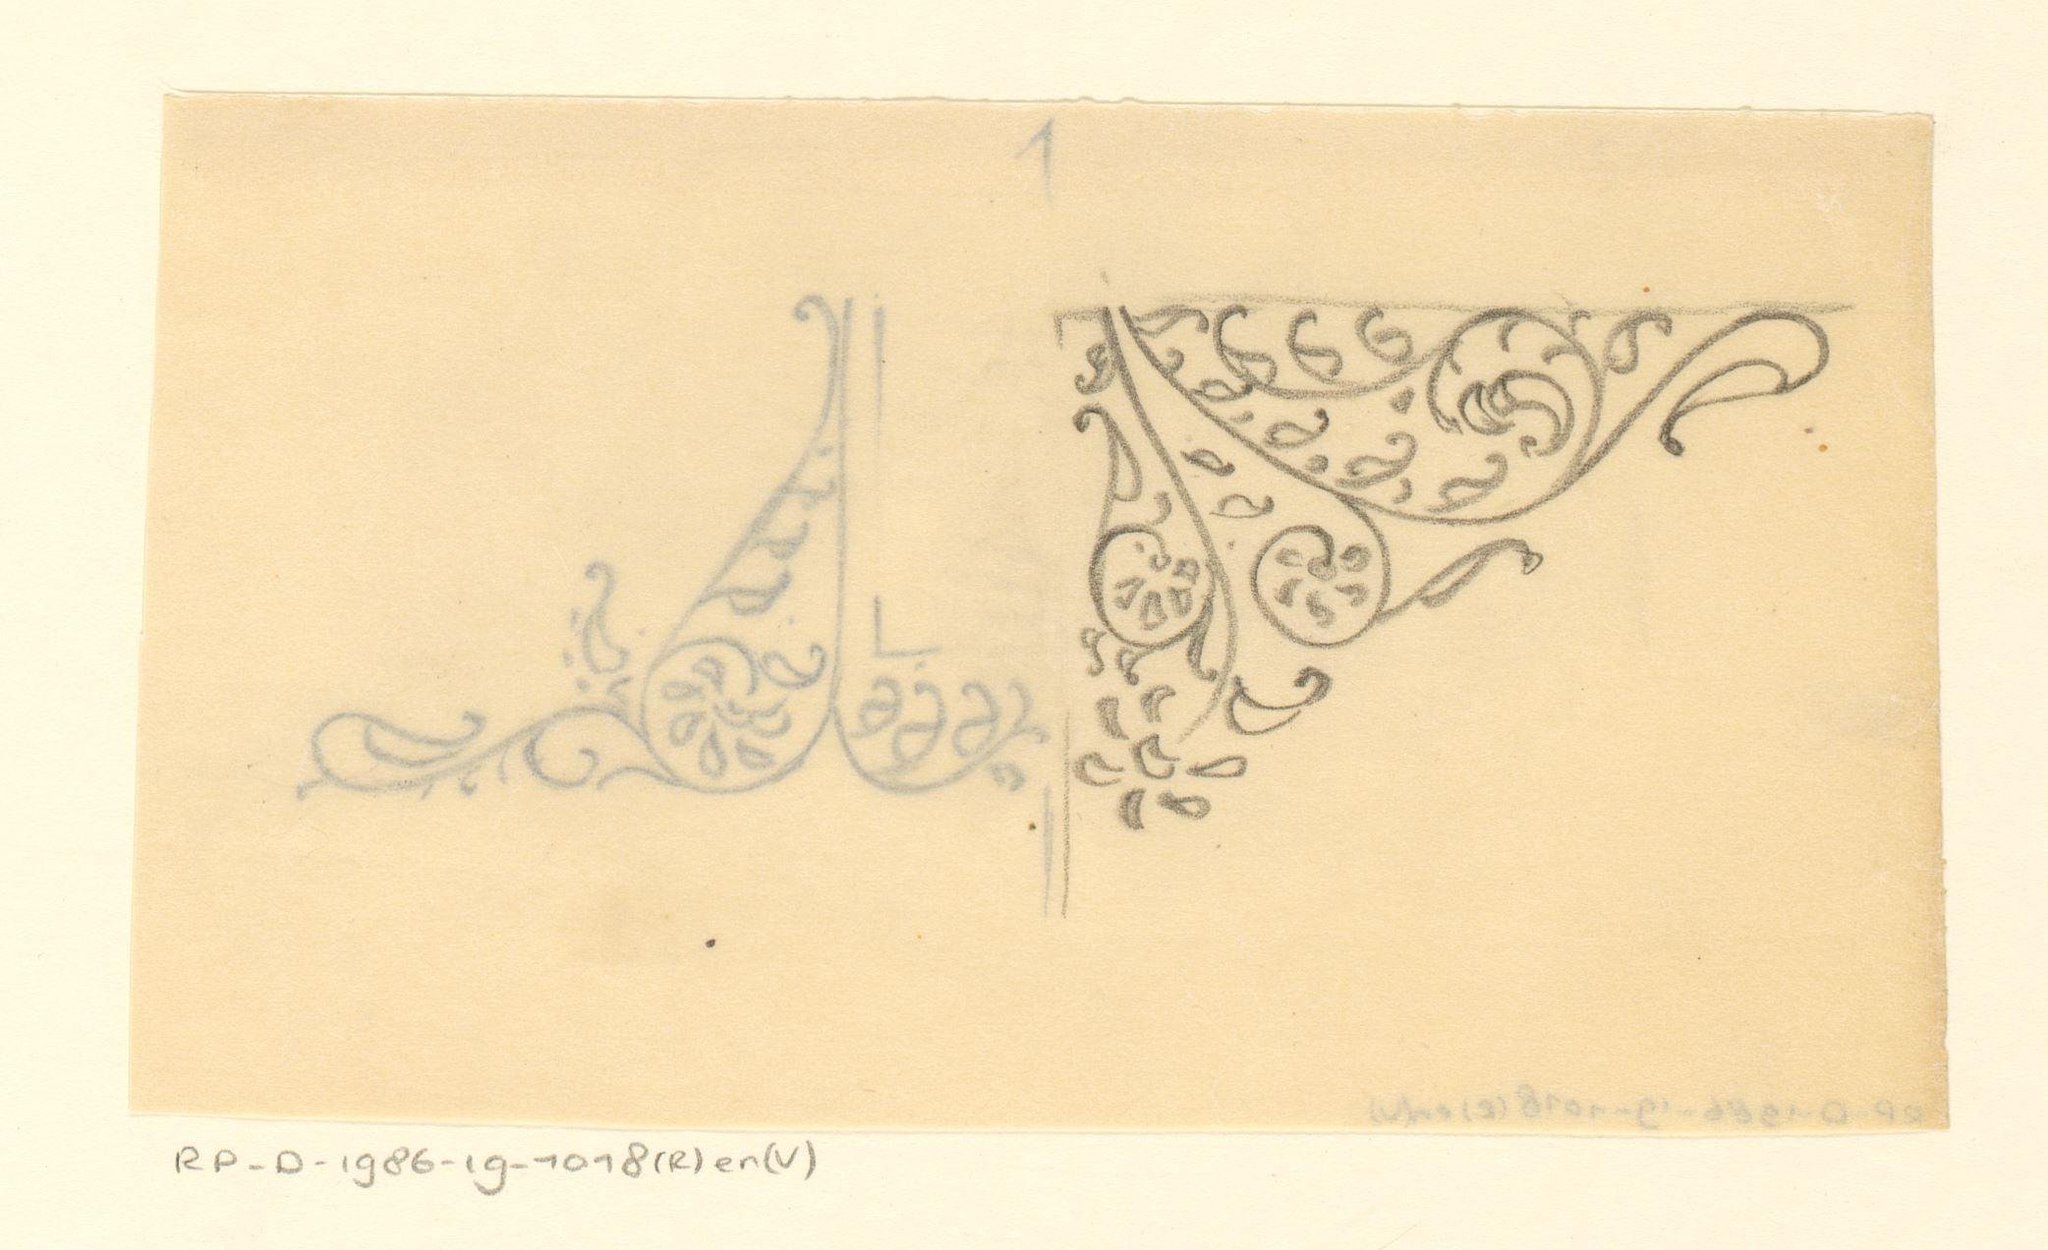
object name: design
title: Bloemornament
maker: reinier willem petrus de vries (1874-1953)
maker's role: draughtsman, print maker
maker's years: 1874-1953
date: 1884-1952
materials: pencil, paper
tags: flowers ~ ornament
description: Vermoedelijk een ontwerp voor: Ravesteijn, P.J. Gedenkboek Hilversum 1424-1924. Hilversum: Gemeente Hilversum, 1924.